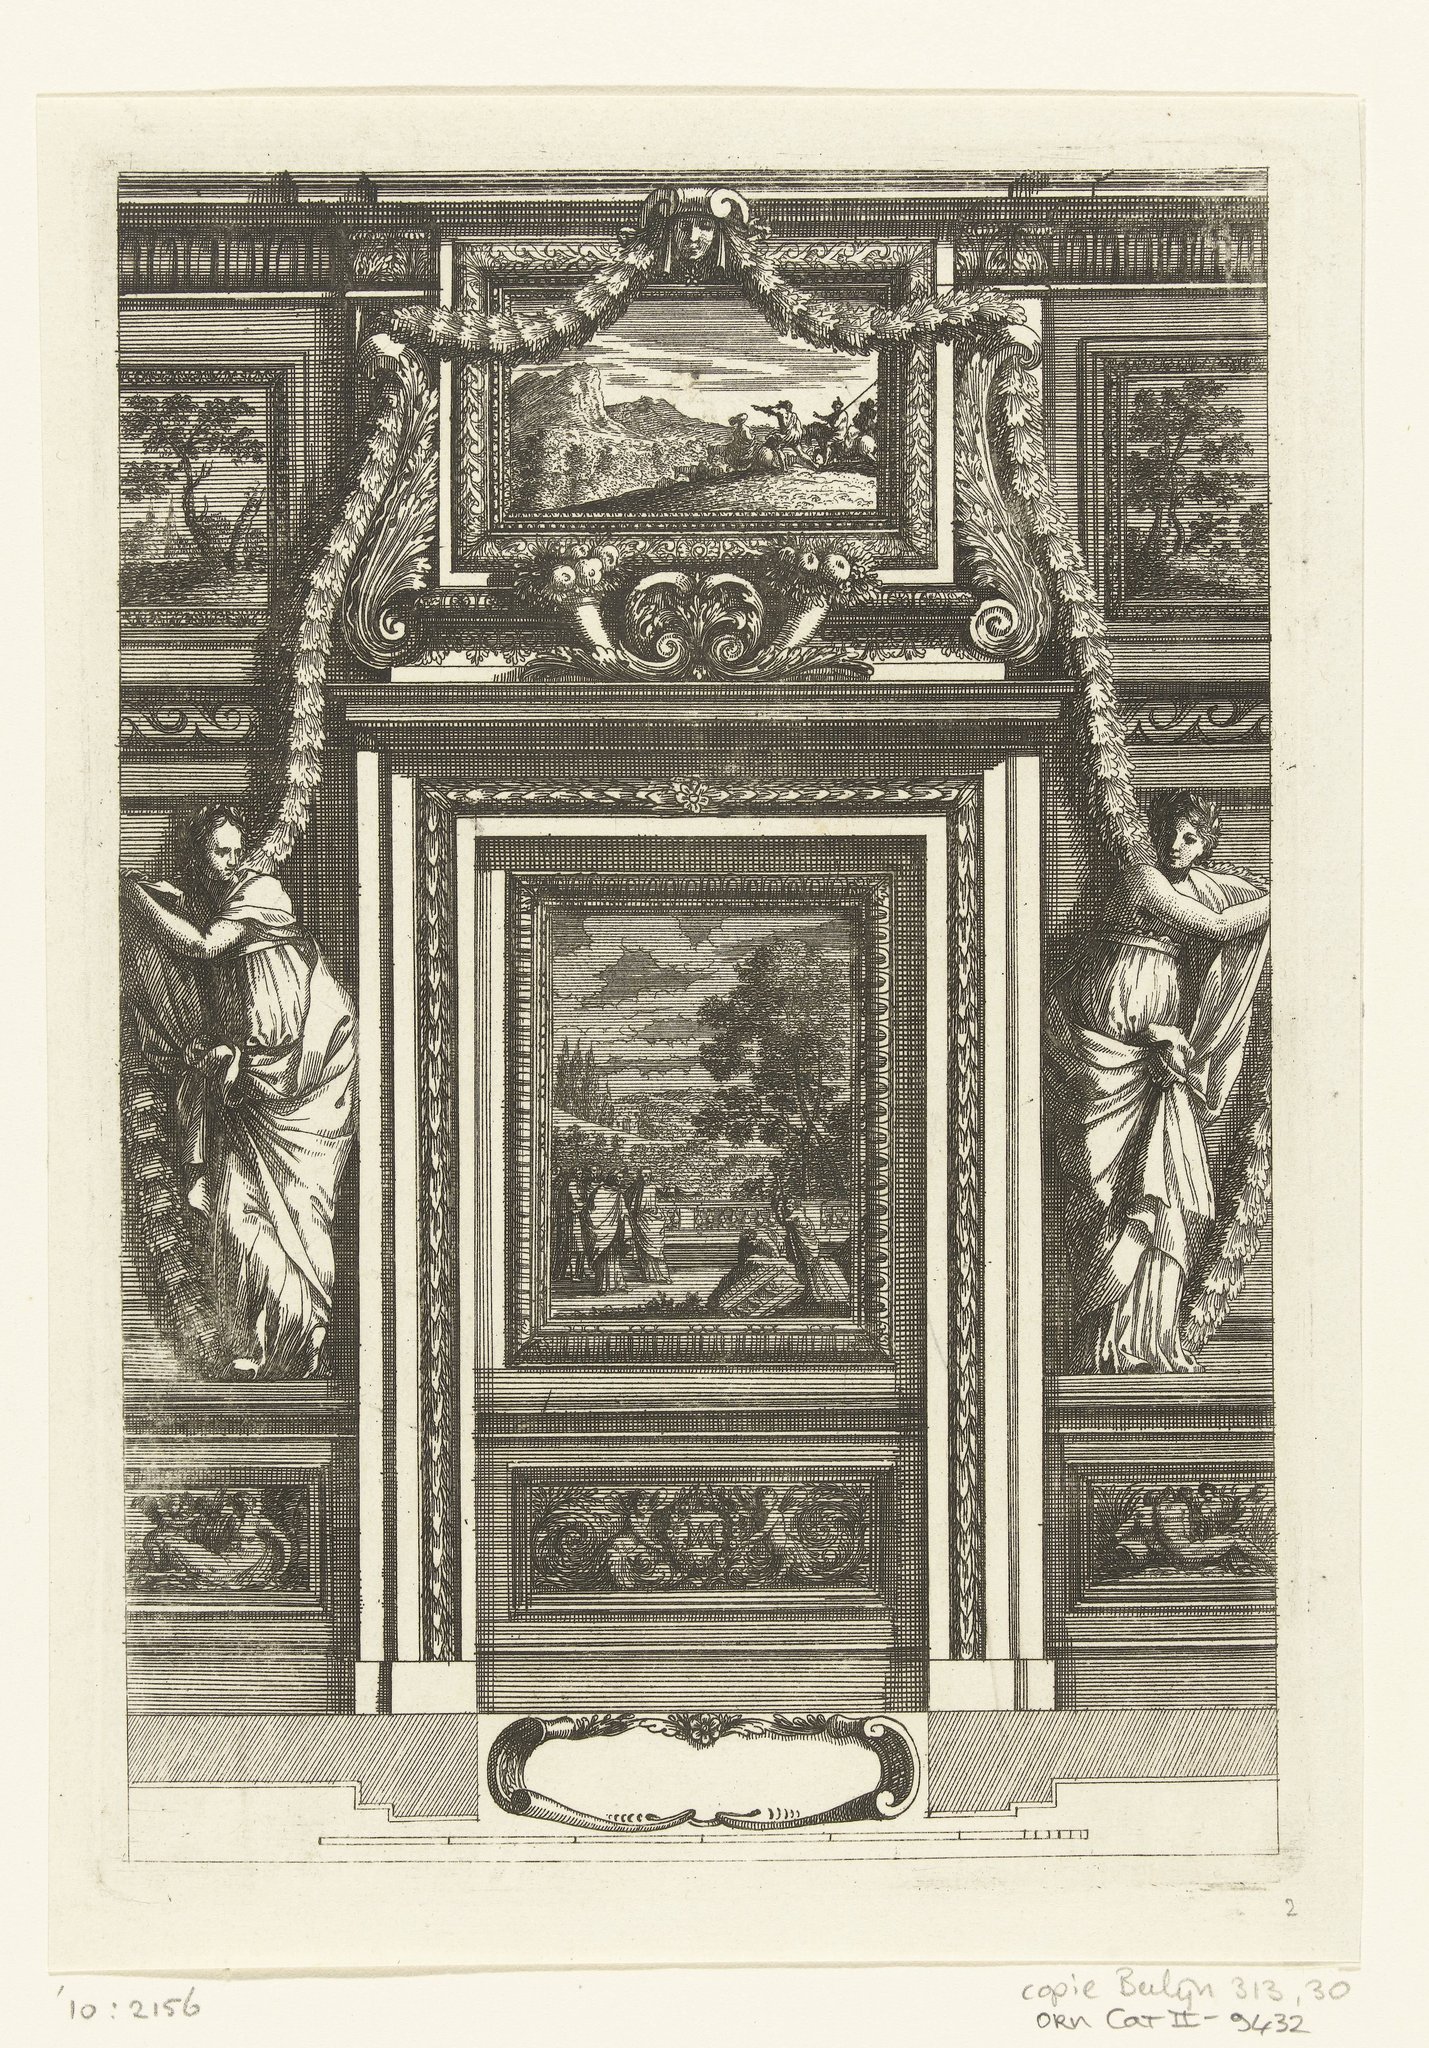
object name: ornament print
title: Deur met schilderij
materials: paper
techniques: engraving, etching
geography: antwerp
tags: door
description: Op het schilderij staan figuren op een balkon met daarachter een landschap, onderaan bevindt zich een kleiner paneel met het monogram MM. Uit serie van 6 bladen met ornamentele panelen en deuren voor kamers en alkoven.